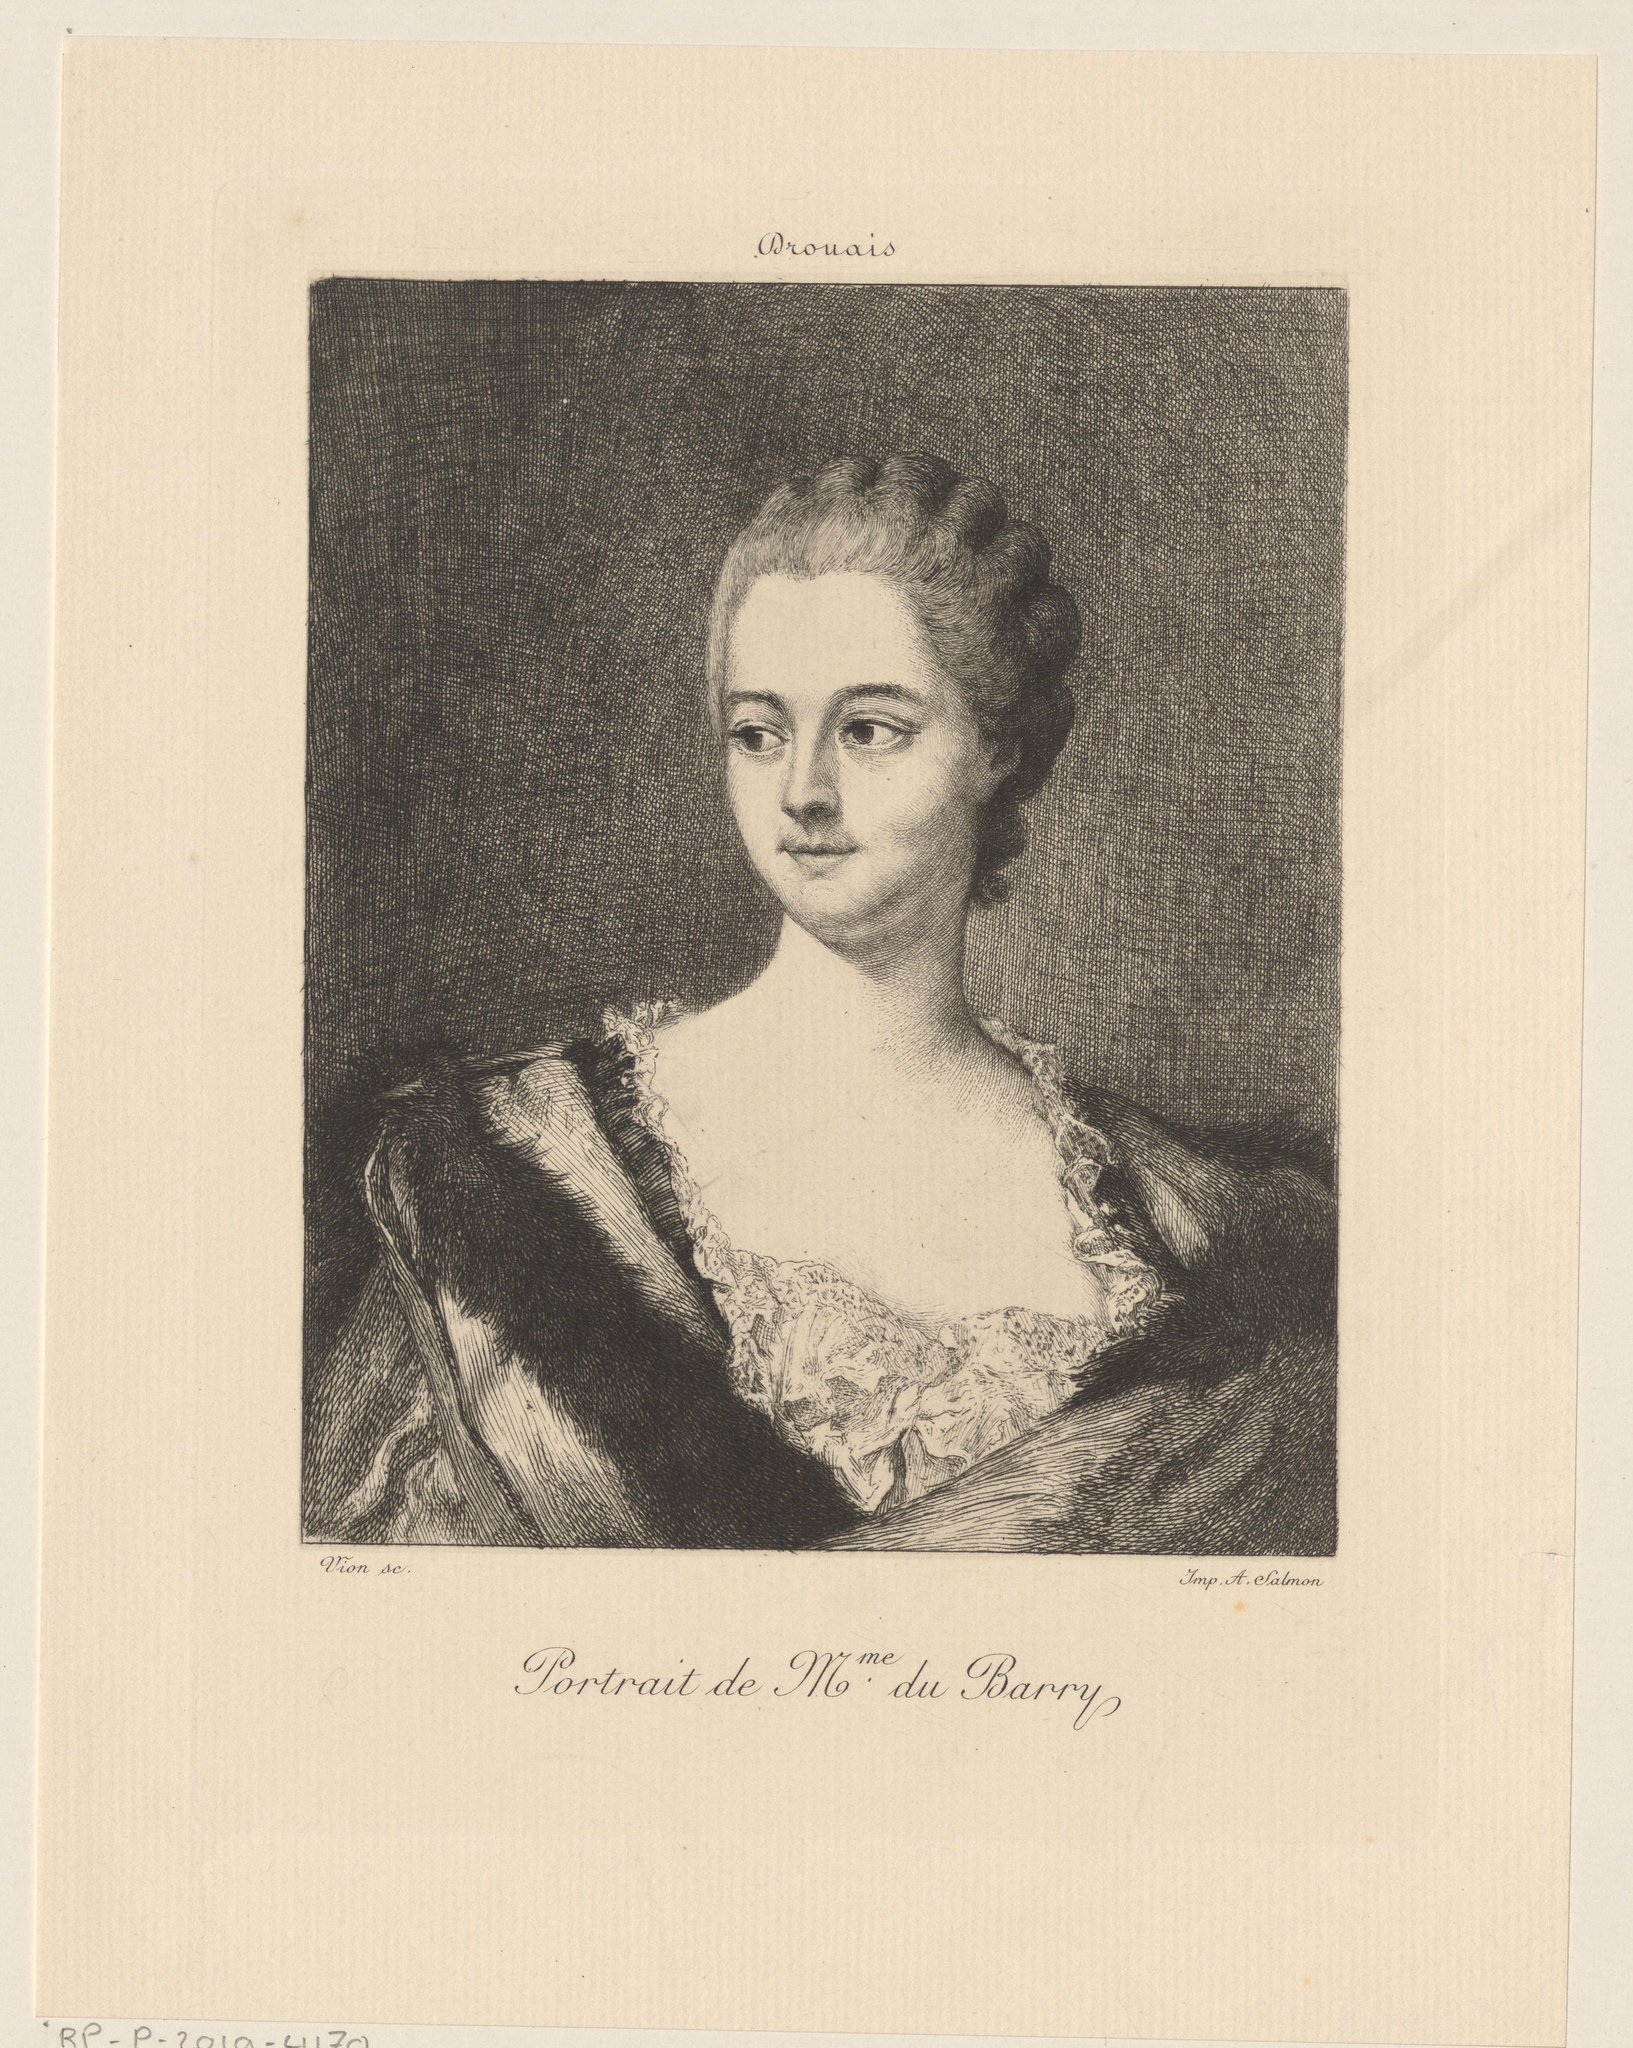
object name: print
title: Portret van Marie-Jeanne Bécu, Madame du Barry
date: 1873-1891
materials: paper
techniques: engraving, etching, retroussage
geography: paris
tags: paris, historical persons - bb - woman